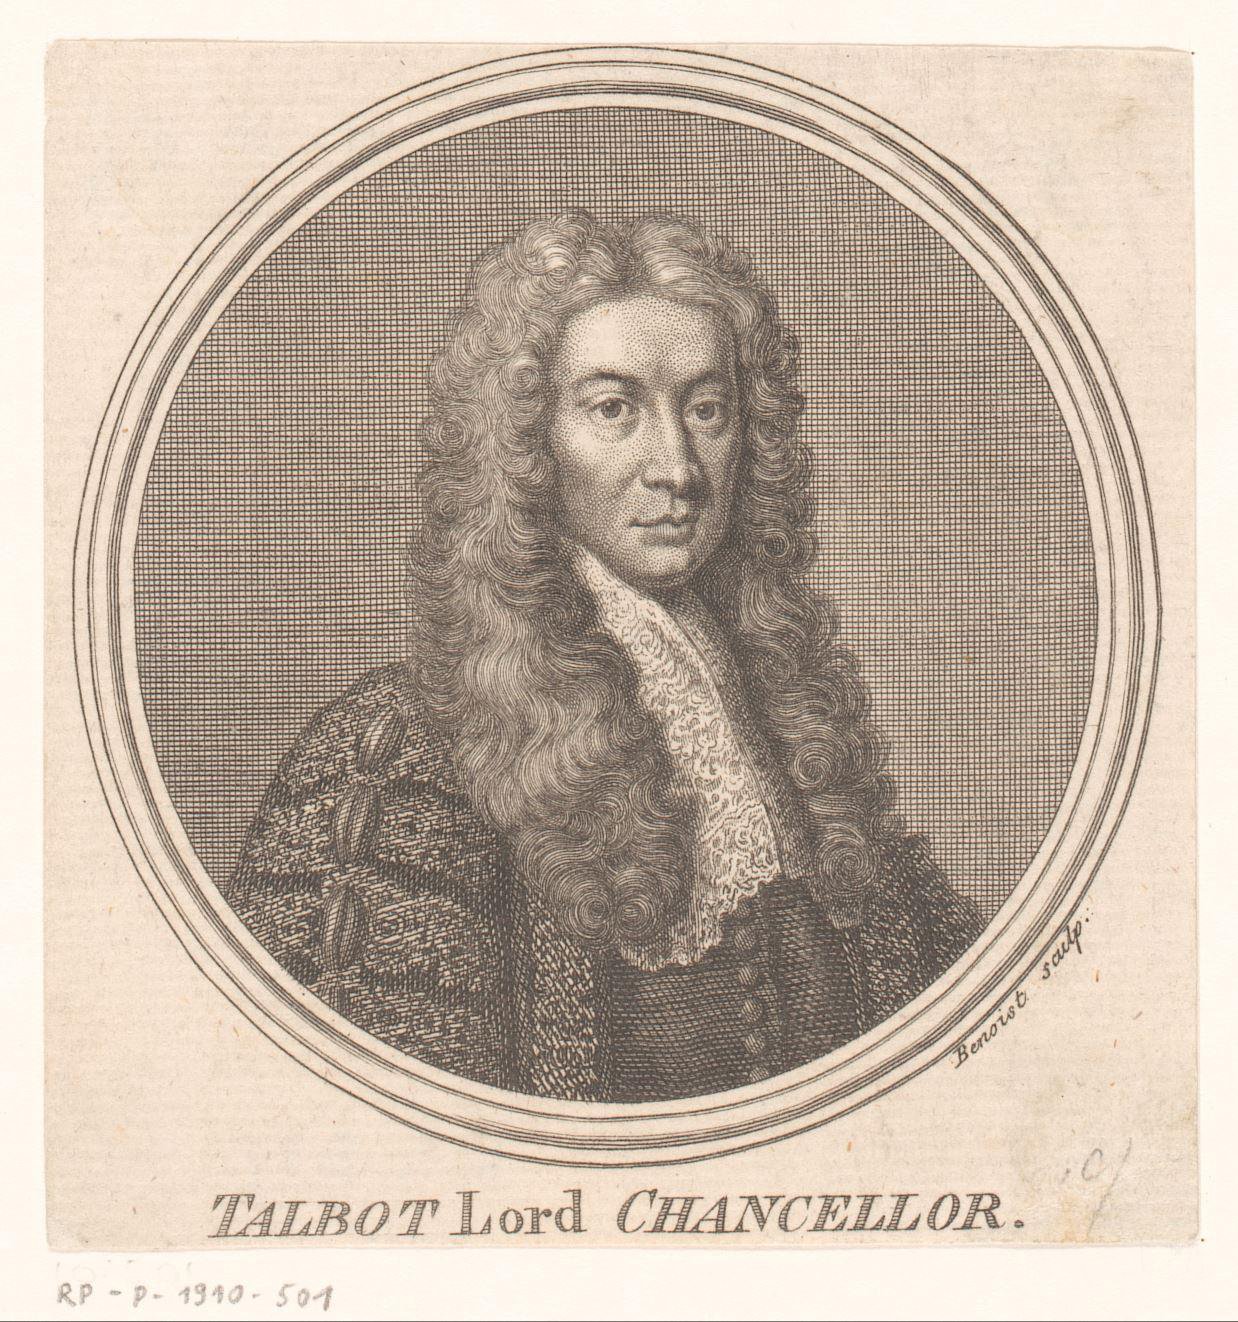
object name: print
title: Talbot Lord Chancellor.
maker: guillaume philippe benoist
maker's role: print maker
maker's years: 1725-1800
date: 1735-1800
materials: paper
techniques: engraving, etching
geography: france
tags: politician, ornament ~ medallion, historical persons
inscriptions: collector's mark: Lugt 2228